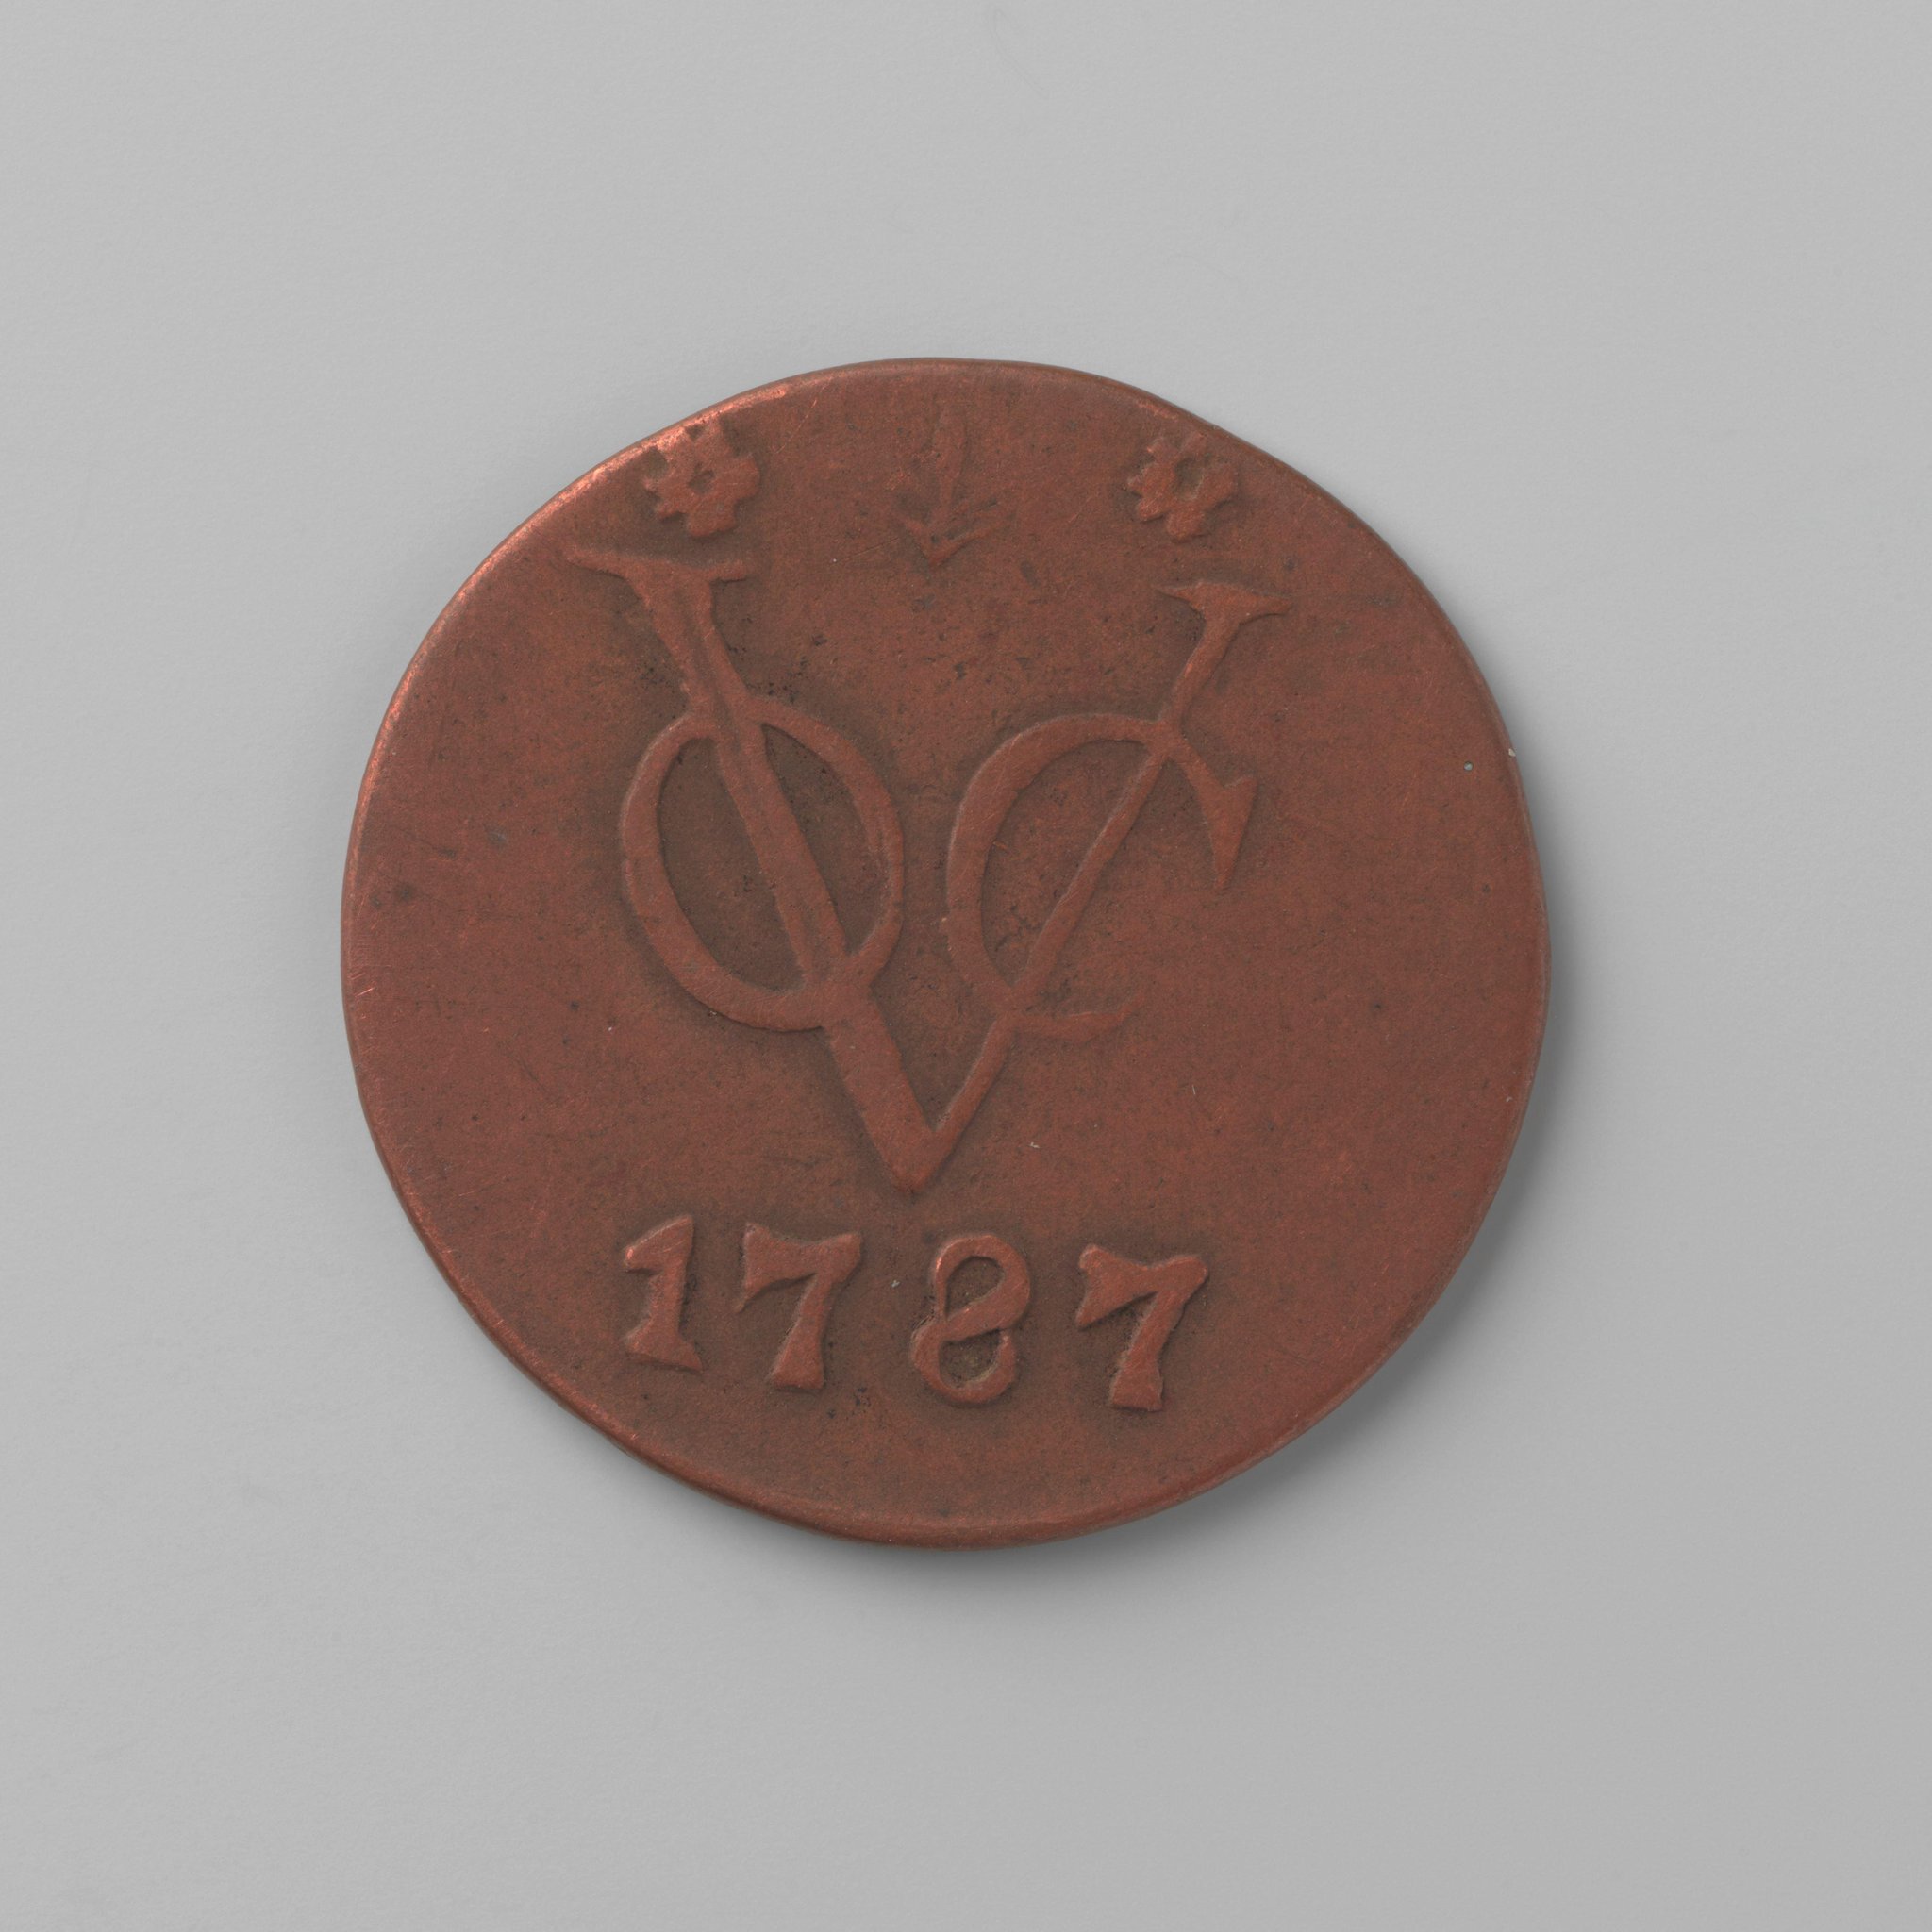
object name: coin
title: Duit van de VOC uit Gelderland,1787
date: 1787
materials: copper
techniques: striking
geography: harderwijk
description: Koperen munt. Voorzijde: tussen wapenspreuk gekroond wapenschild van Gelderland. Keerzijde: monogram van de VOC, waarboven muntmeesterteken en waaronder jaartal. Gladde rand.